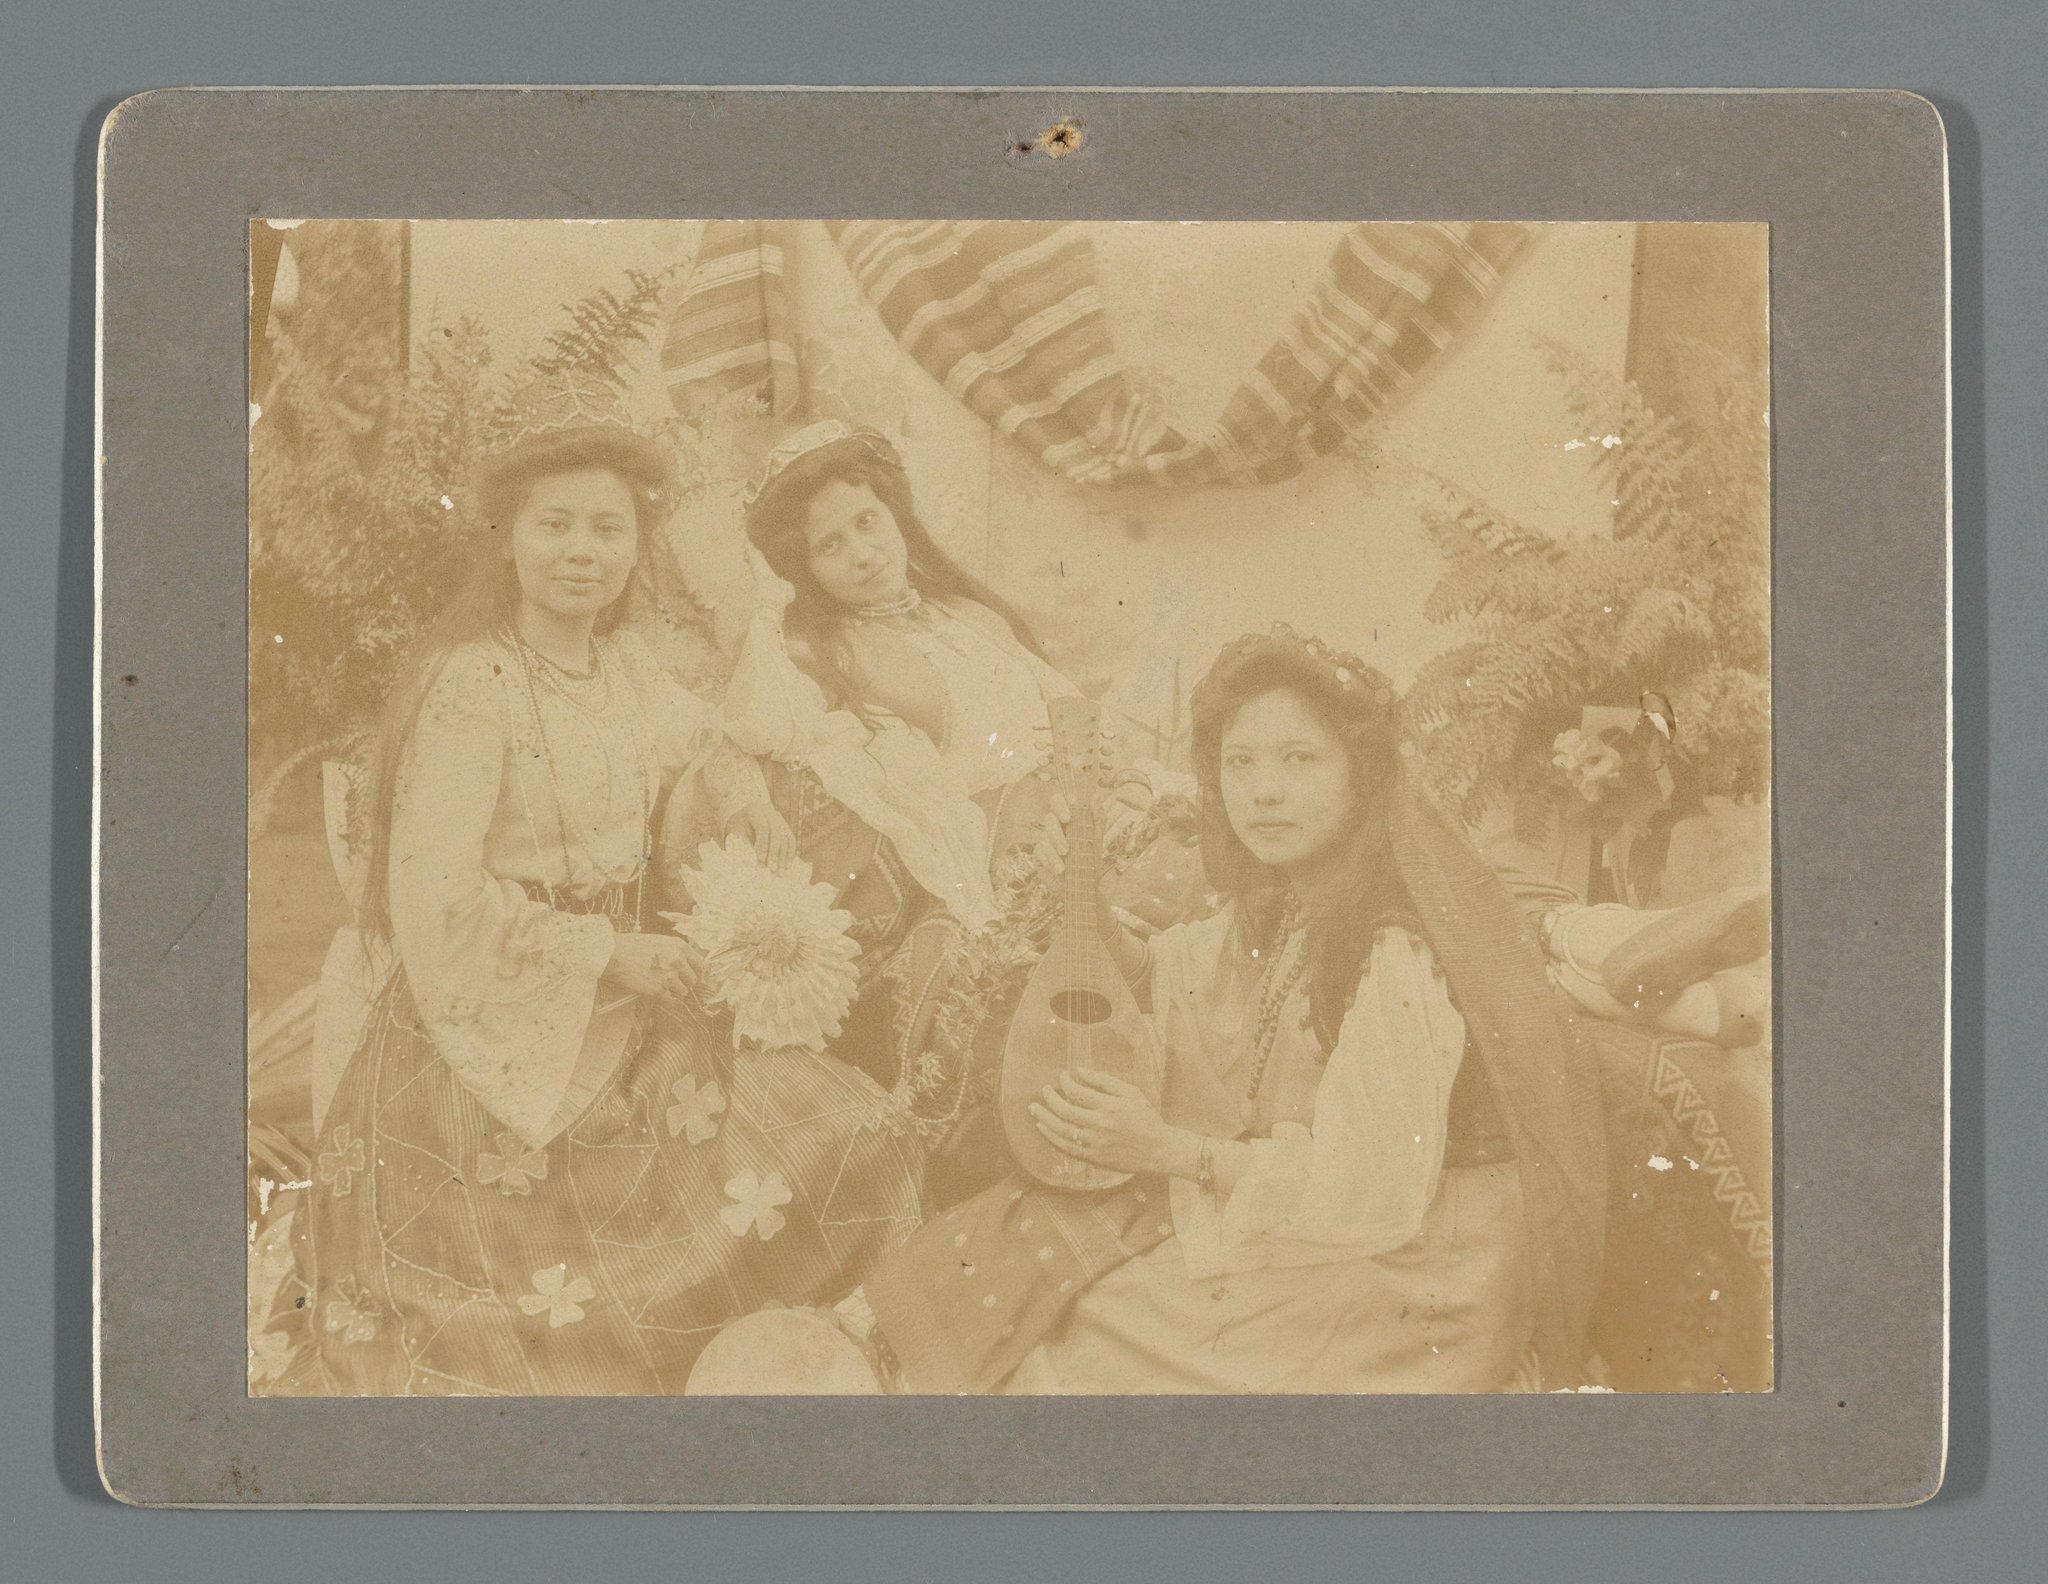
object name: photograph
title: Portret van Guusje Bruins, verkleed en met mandoline en twee vriendinnen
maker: Anonymous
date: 1900-1905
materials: cardboard, photographic support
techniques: gelatin silver print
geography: dutch east indies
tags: adolescent, young woman, maiden, dress-up party, historical persons - bb - woman, dutch east indies, the